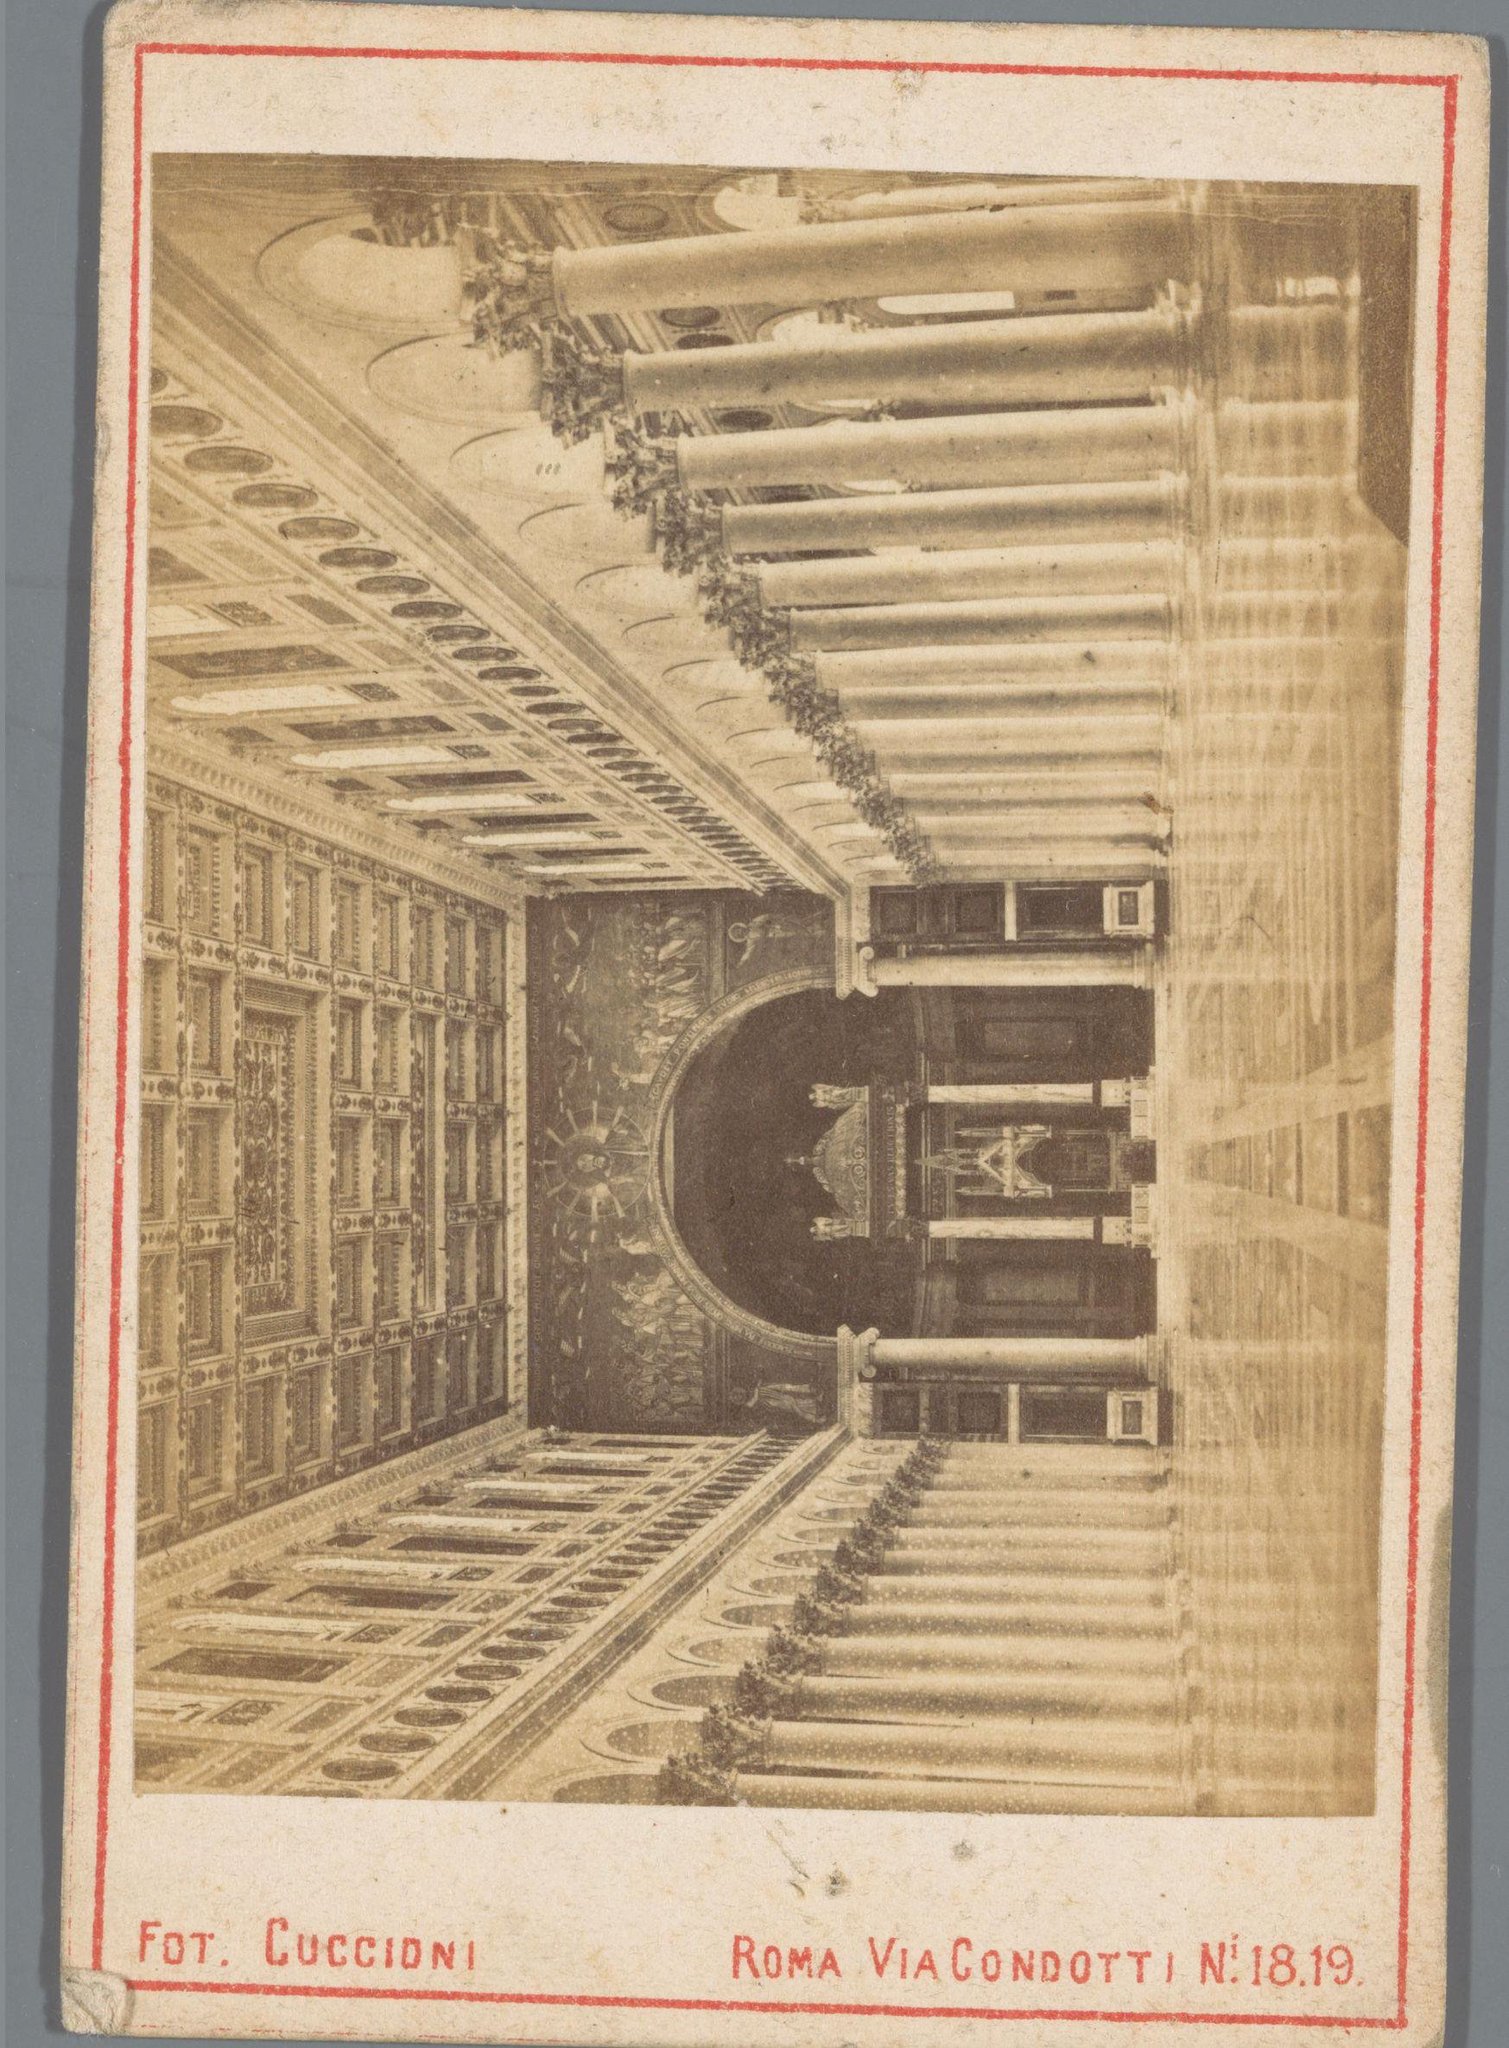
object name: photograph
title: St. Paul à Rome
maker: tomasso cuccioni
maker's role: print maker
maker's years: 1790-1864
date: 1855-1885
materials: cardboard, paper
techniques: albumen print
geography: rome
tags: interior of church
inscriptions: inscription: ‘St. Paul près de Rome’, inscription: ‘Roma Via Condotti Ni. 18.19.’